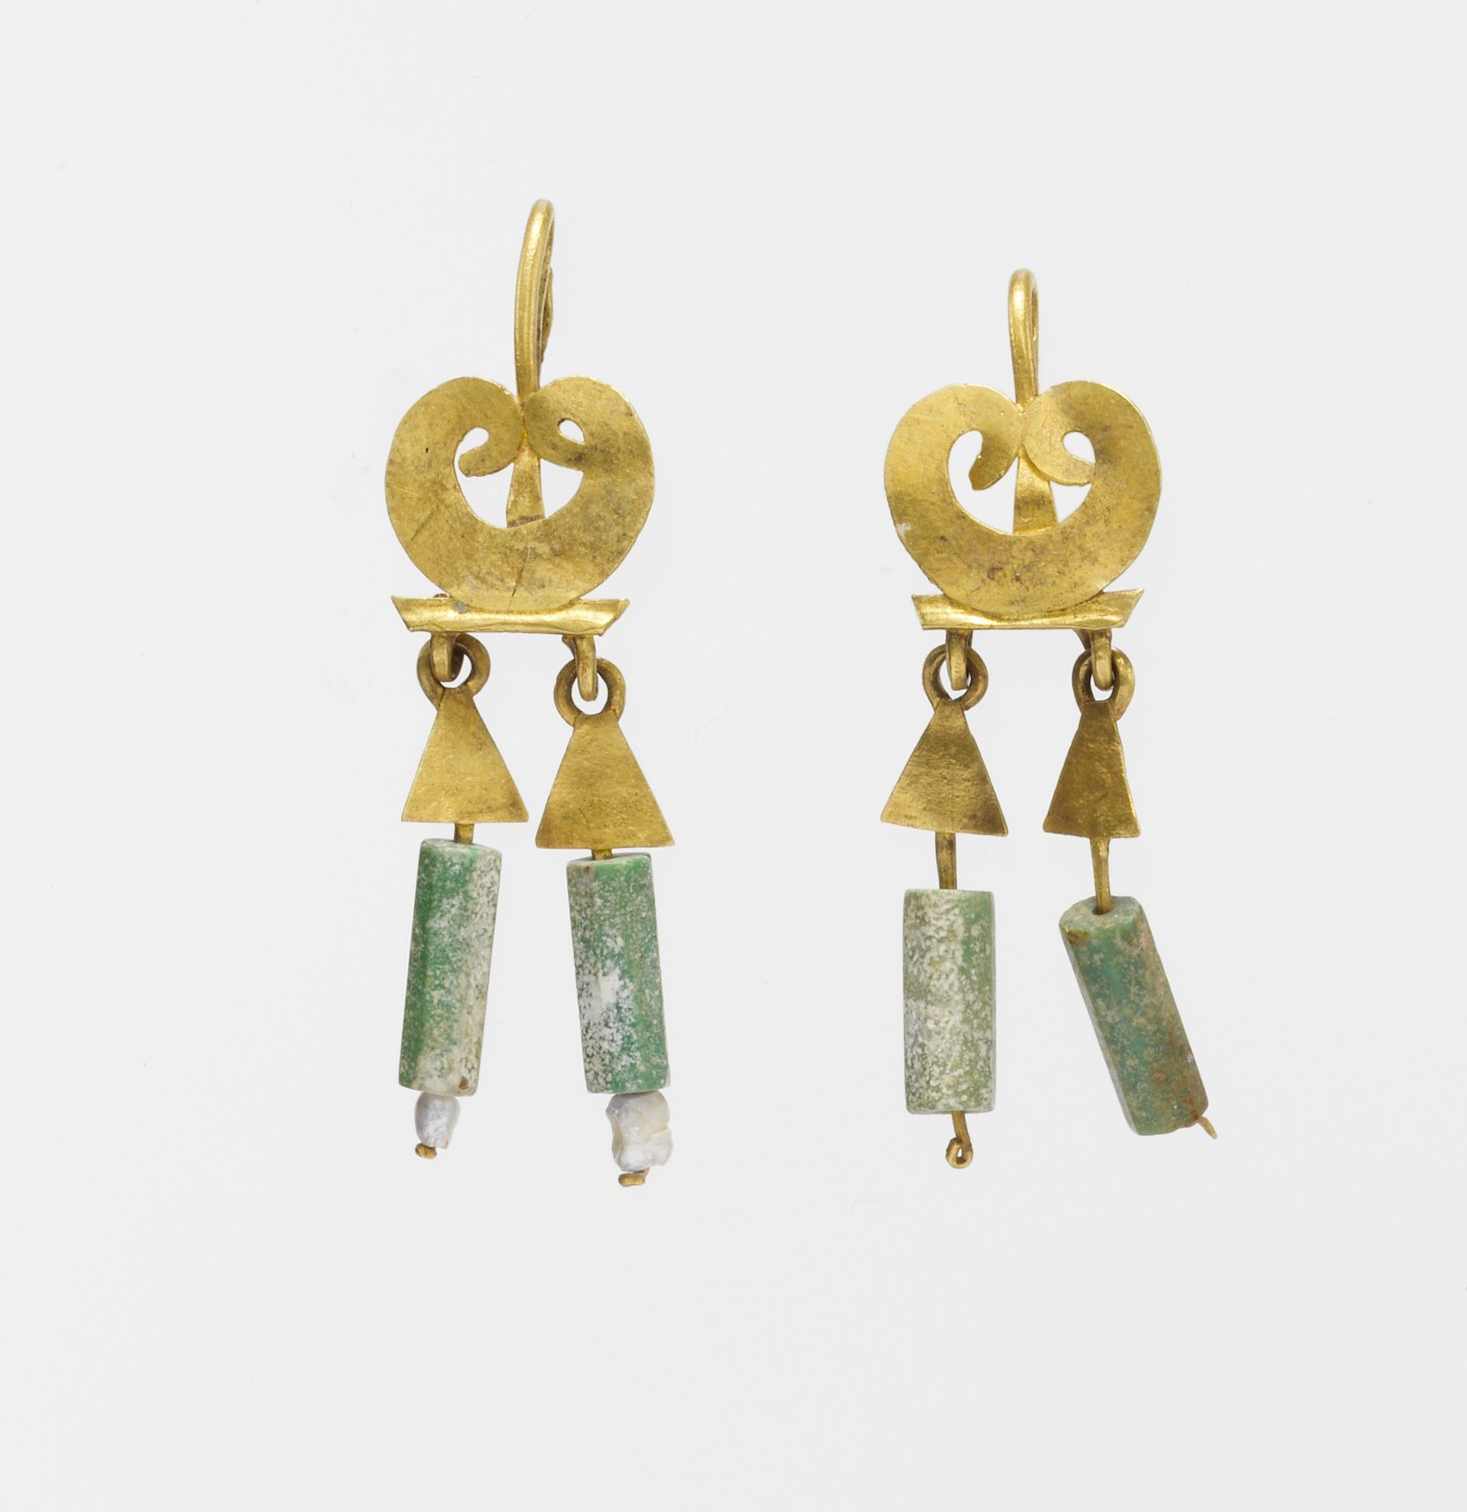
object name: earring hook type with pendant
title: Gold and chalcedony earrings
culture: roman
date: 201-300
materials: stone, gold